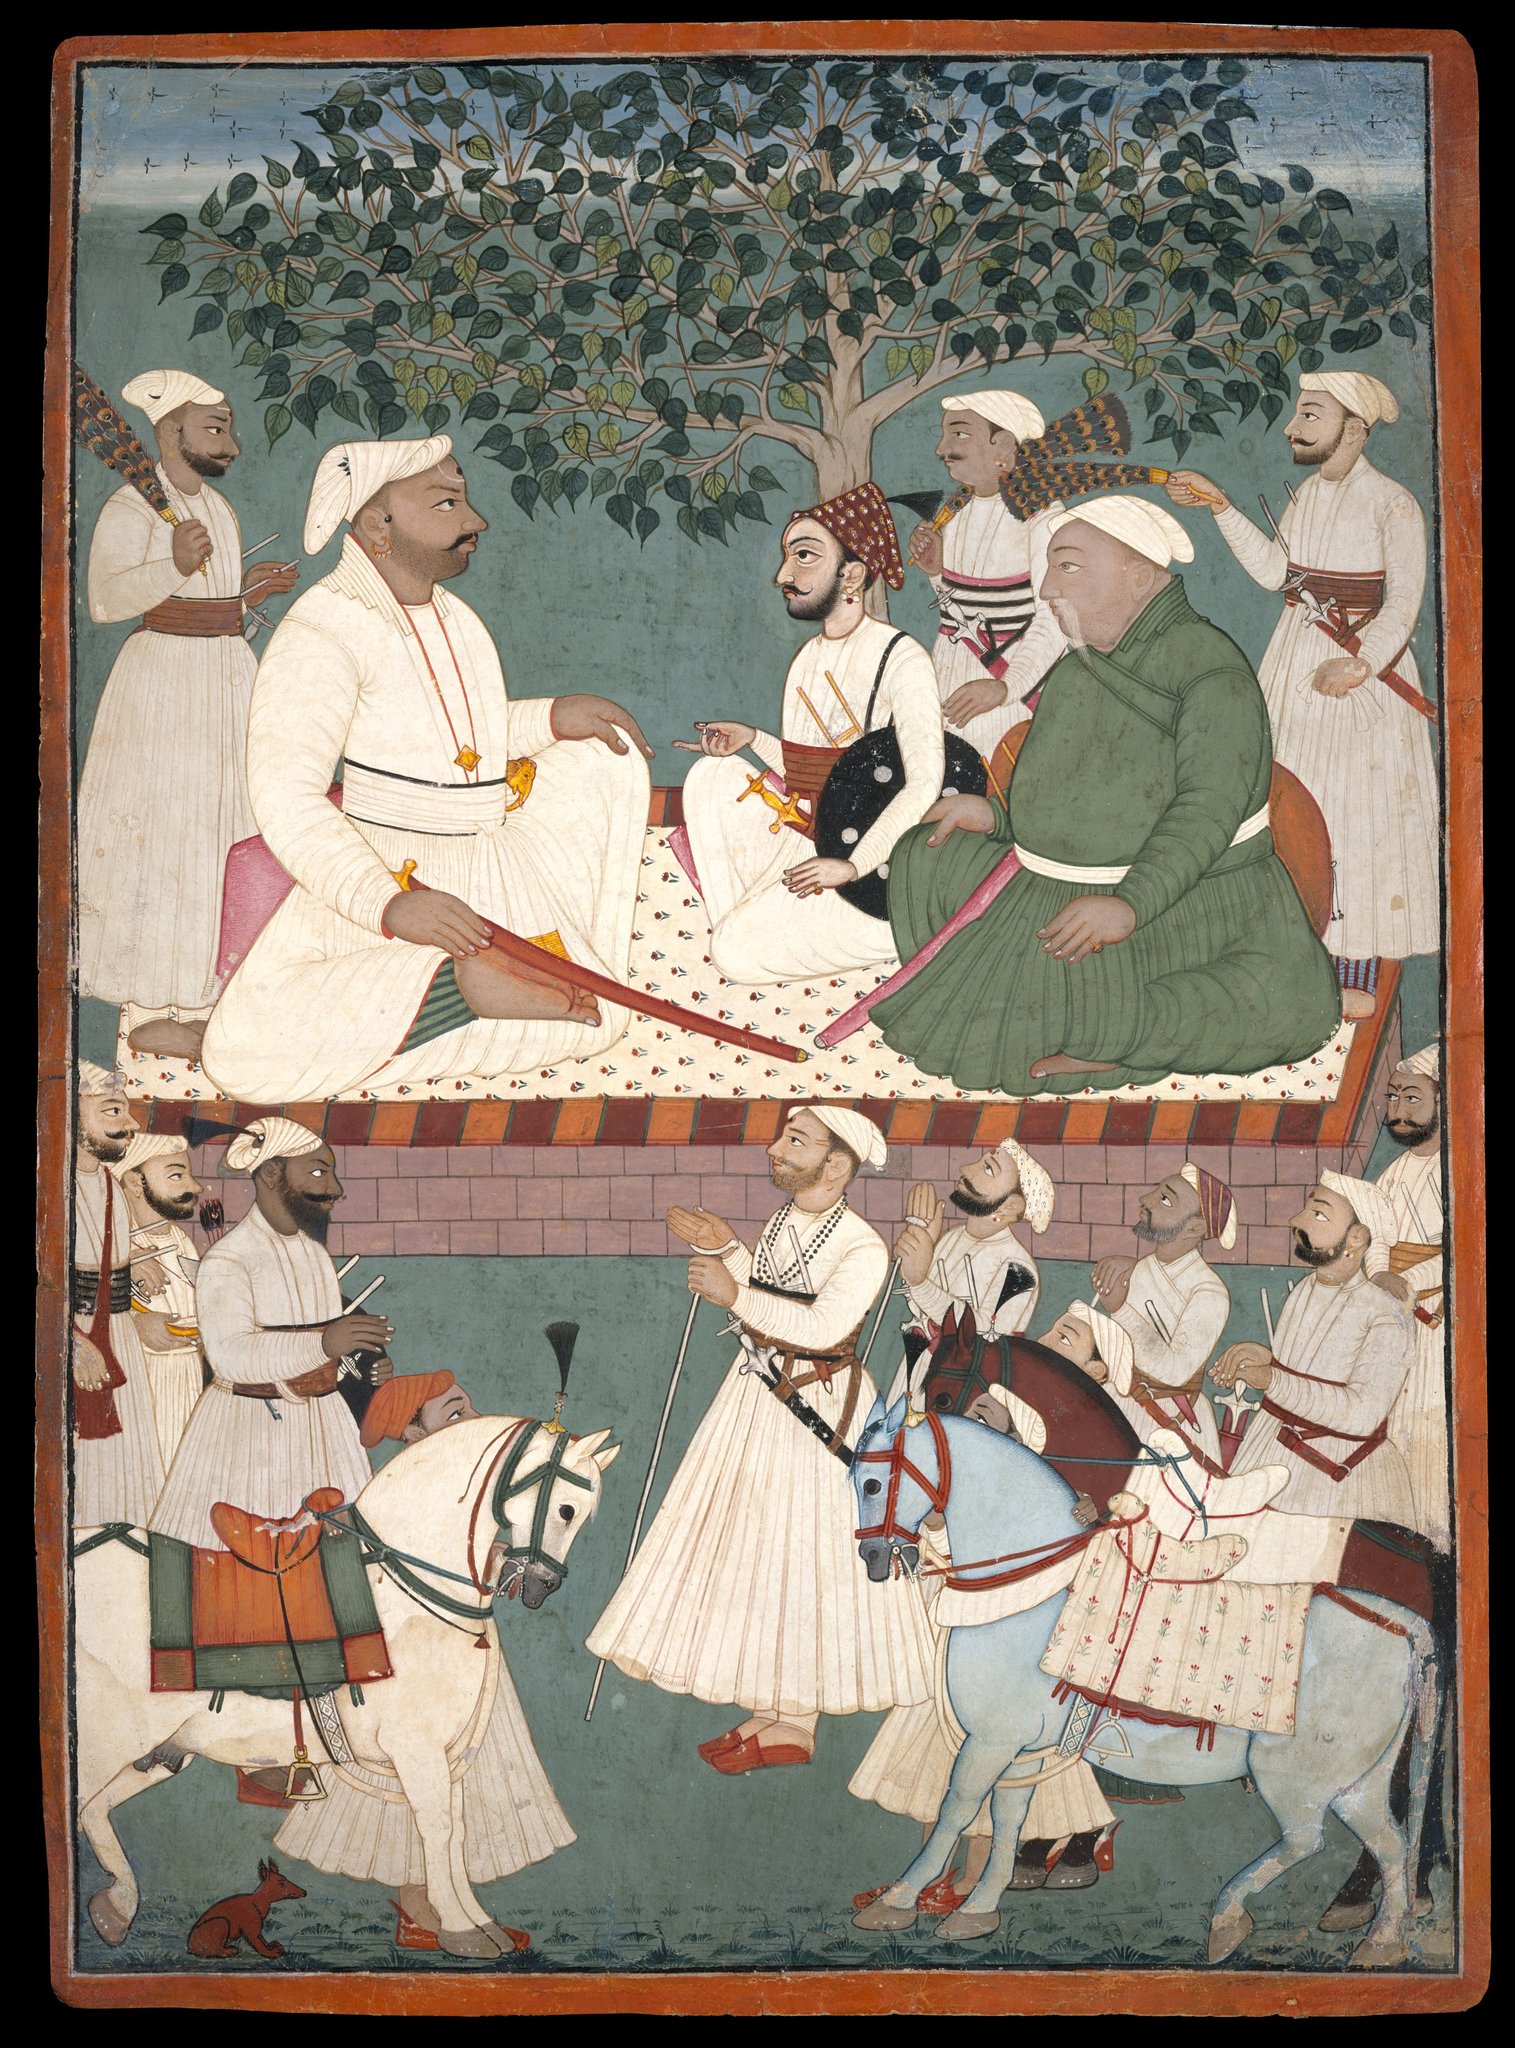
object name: painting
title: Maharaja Sidh Sen Receiving an Embassy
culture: indian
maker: a master of the mandi atelier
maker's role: artist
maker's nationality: indian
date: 1700-1710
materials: ink, paper, watercolor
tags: men,horses